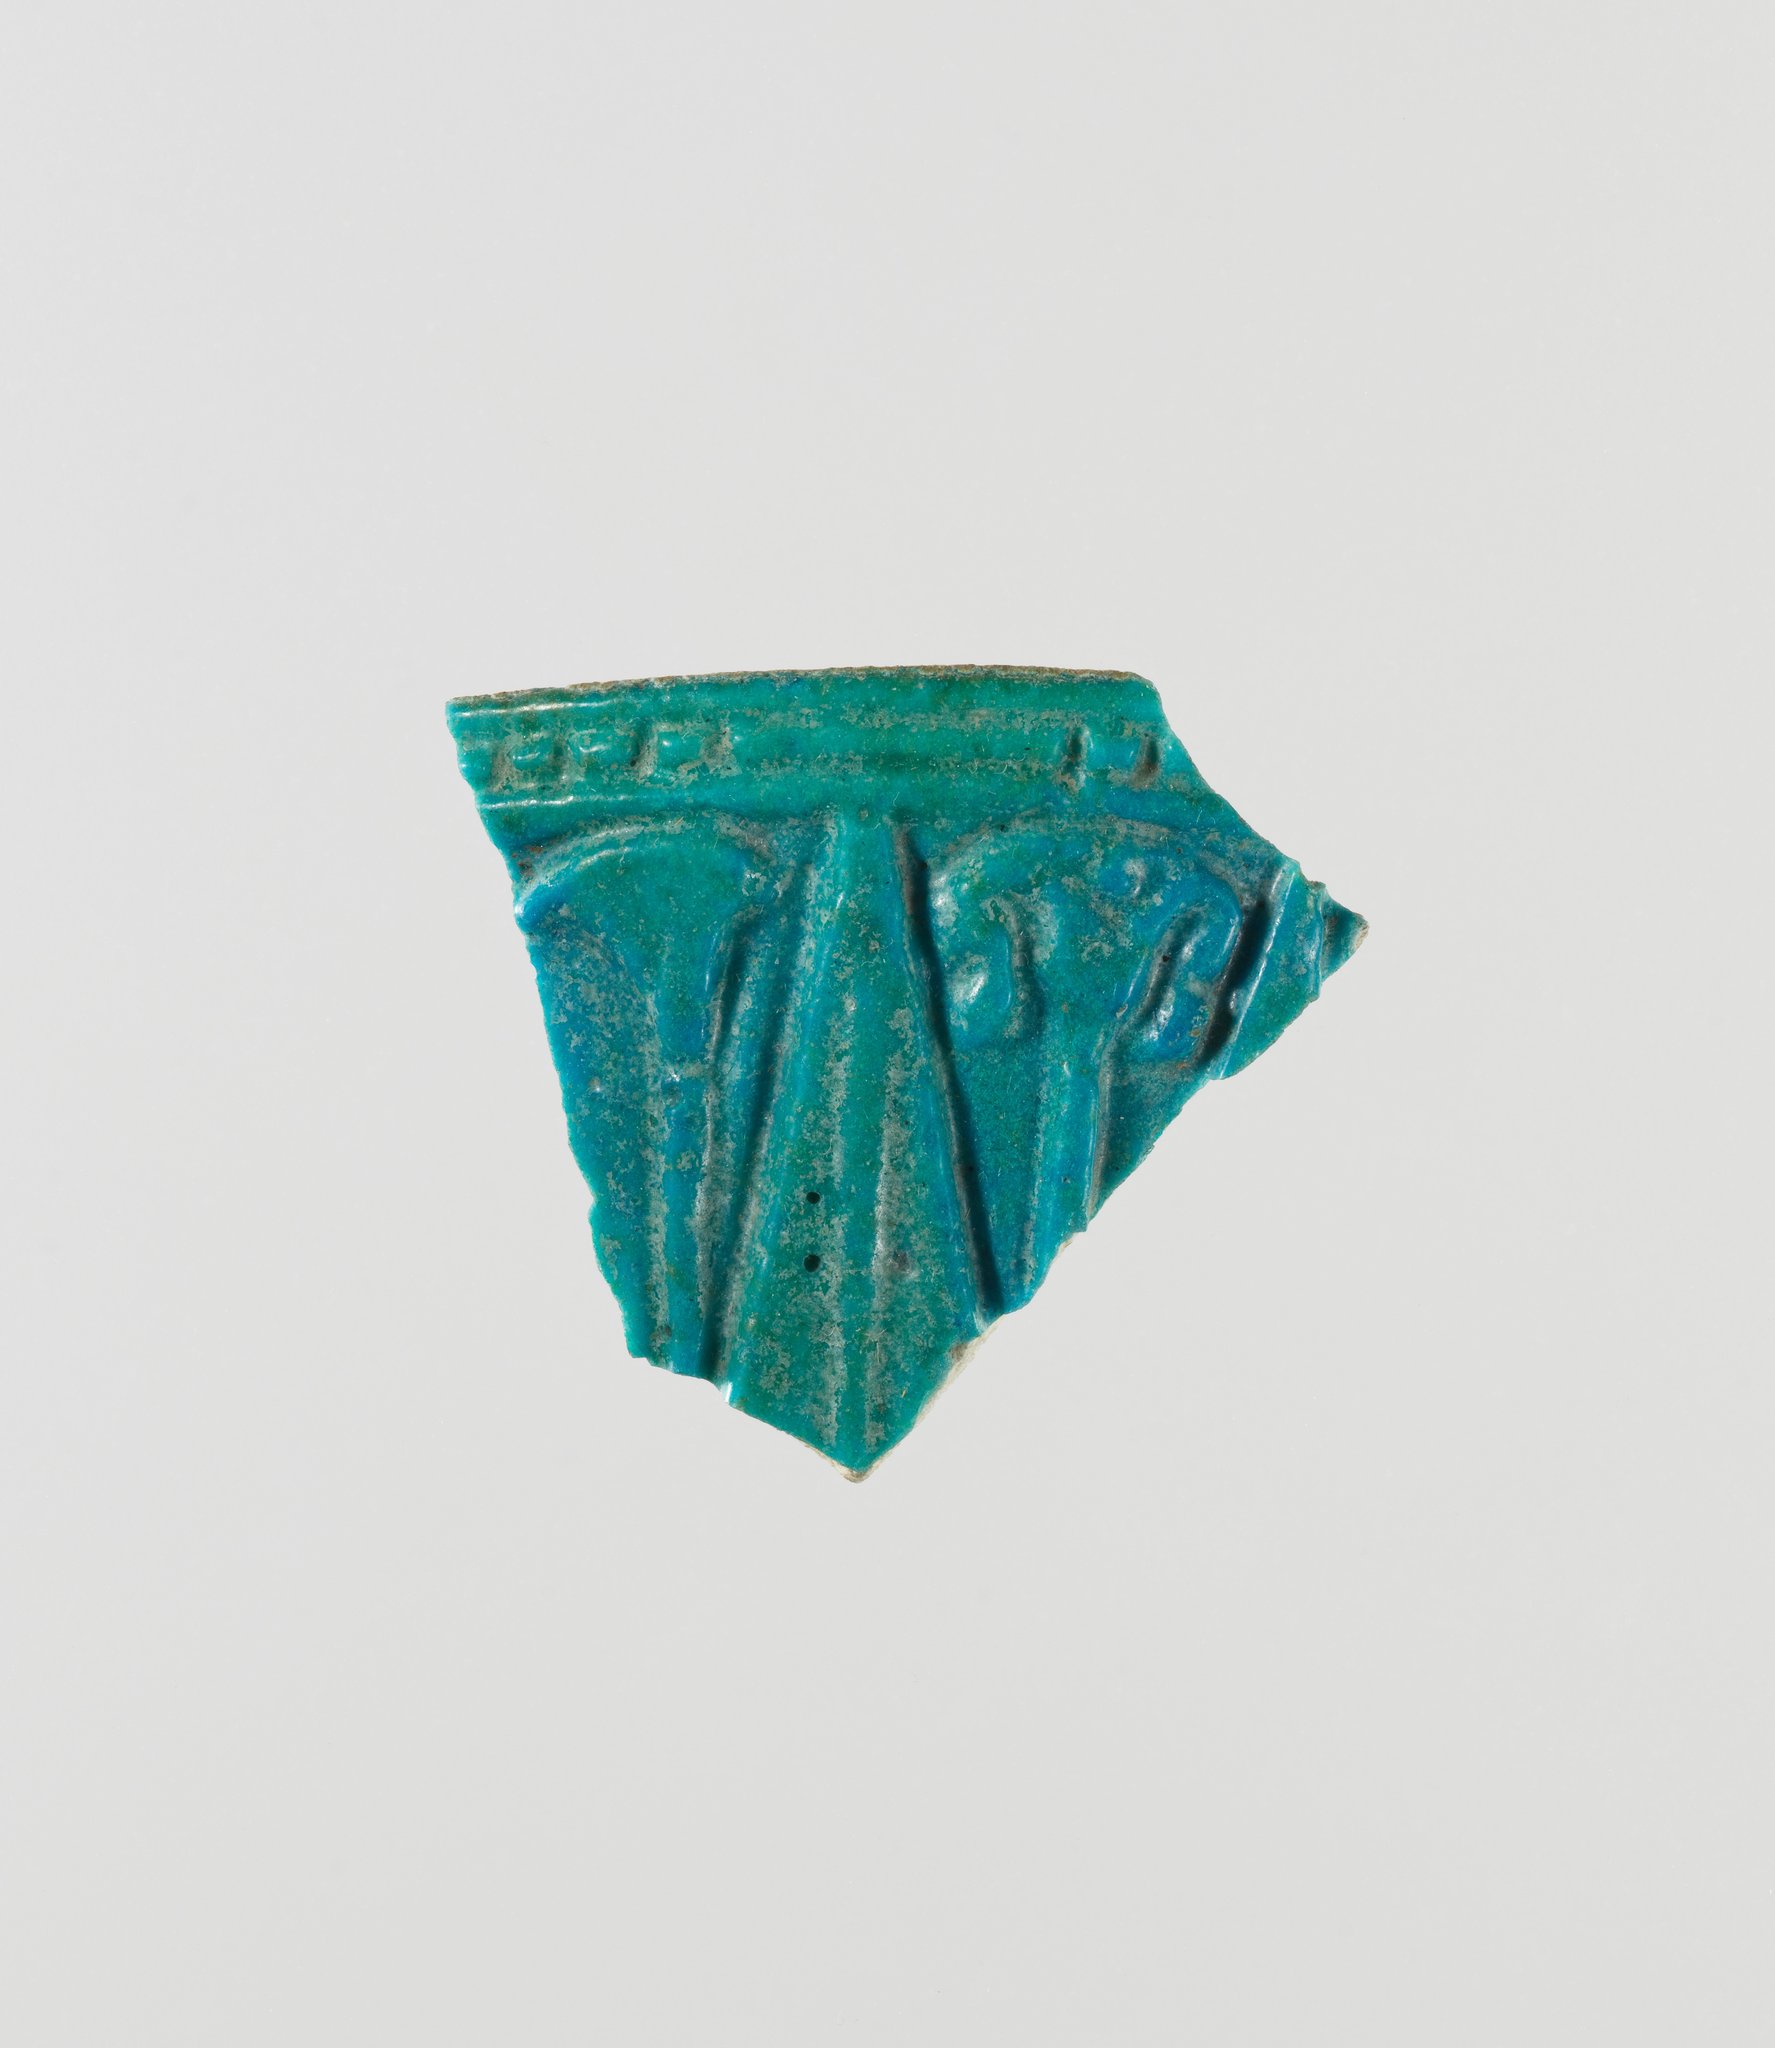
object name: chalice, cup, lotiform, relief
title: Chalice fragment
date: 1070-664 BCE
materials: faience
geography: egypt